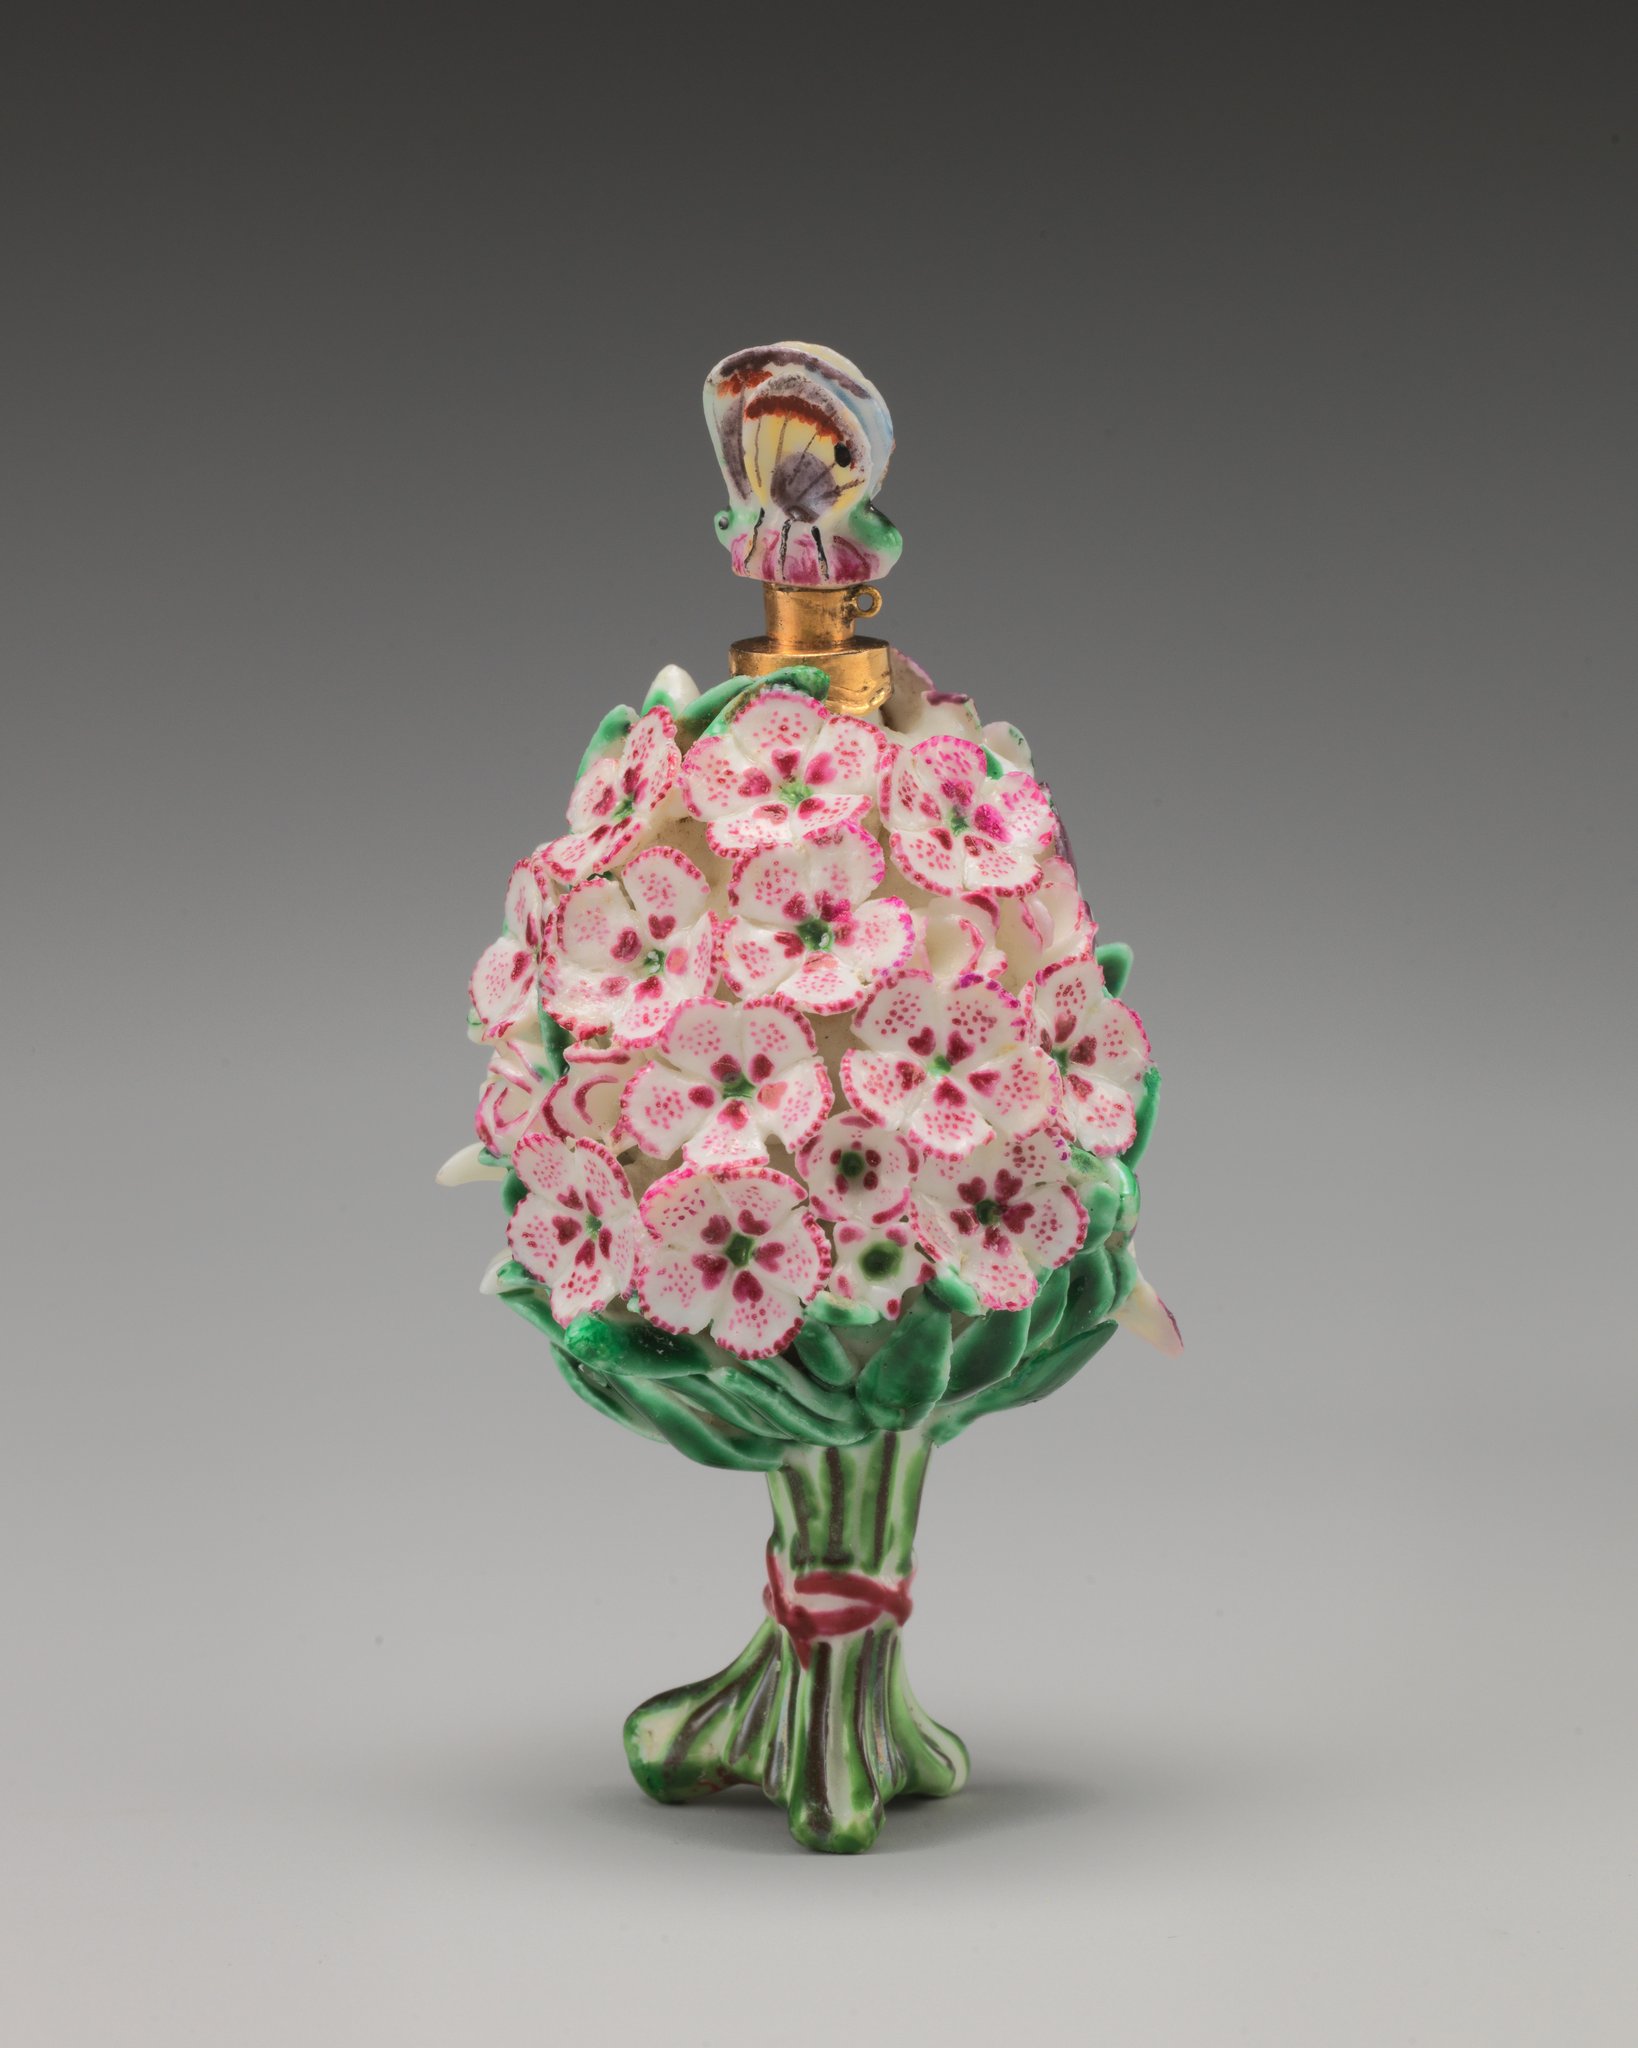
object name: toy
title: Bouquet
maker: saint james's factory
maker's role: maker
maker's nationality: british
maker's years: 1749-1759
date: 1760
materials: soft paste porcelain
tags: butterflies,flowers